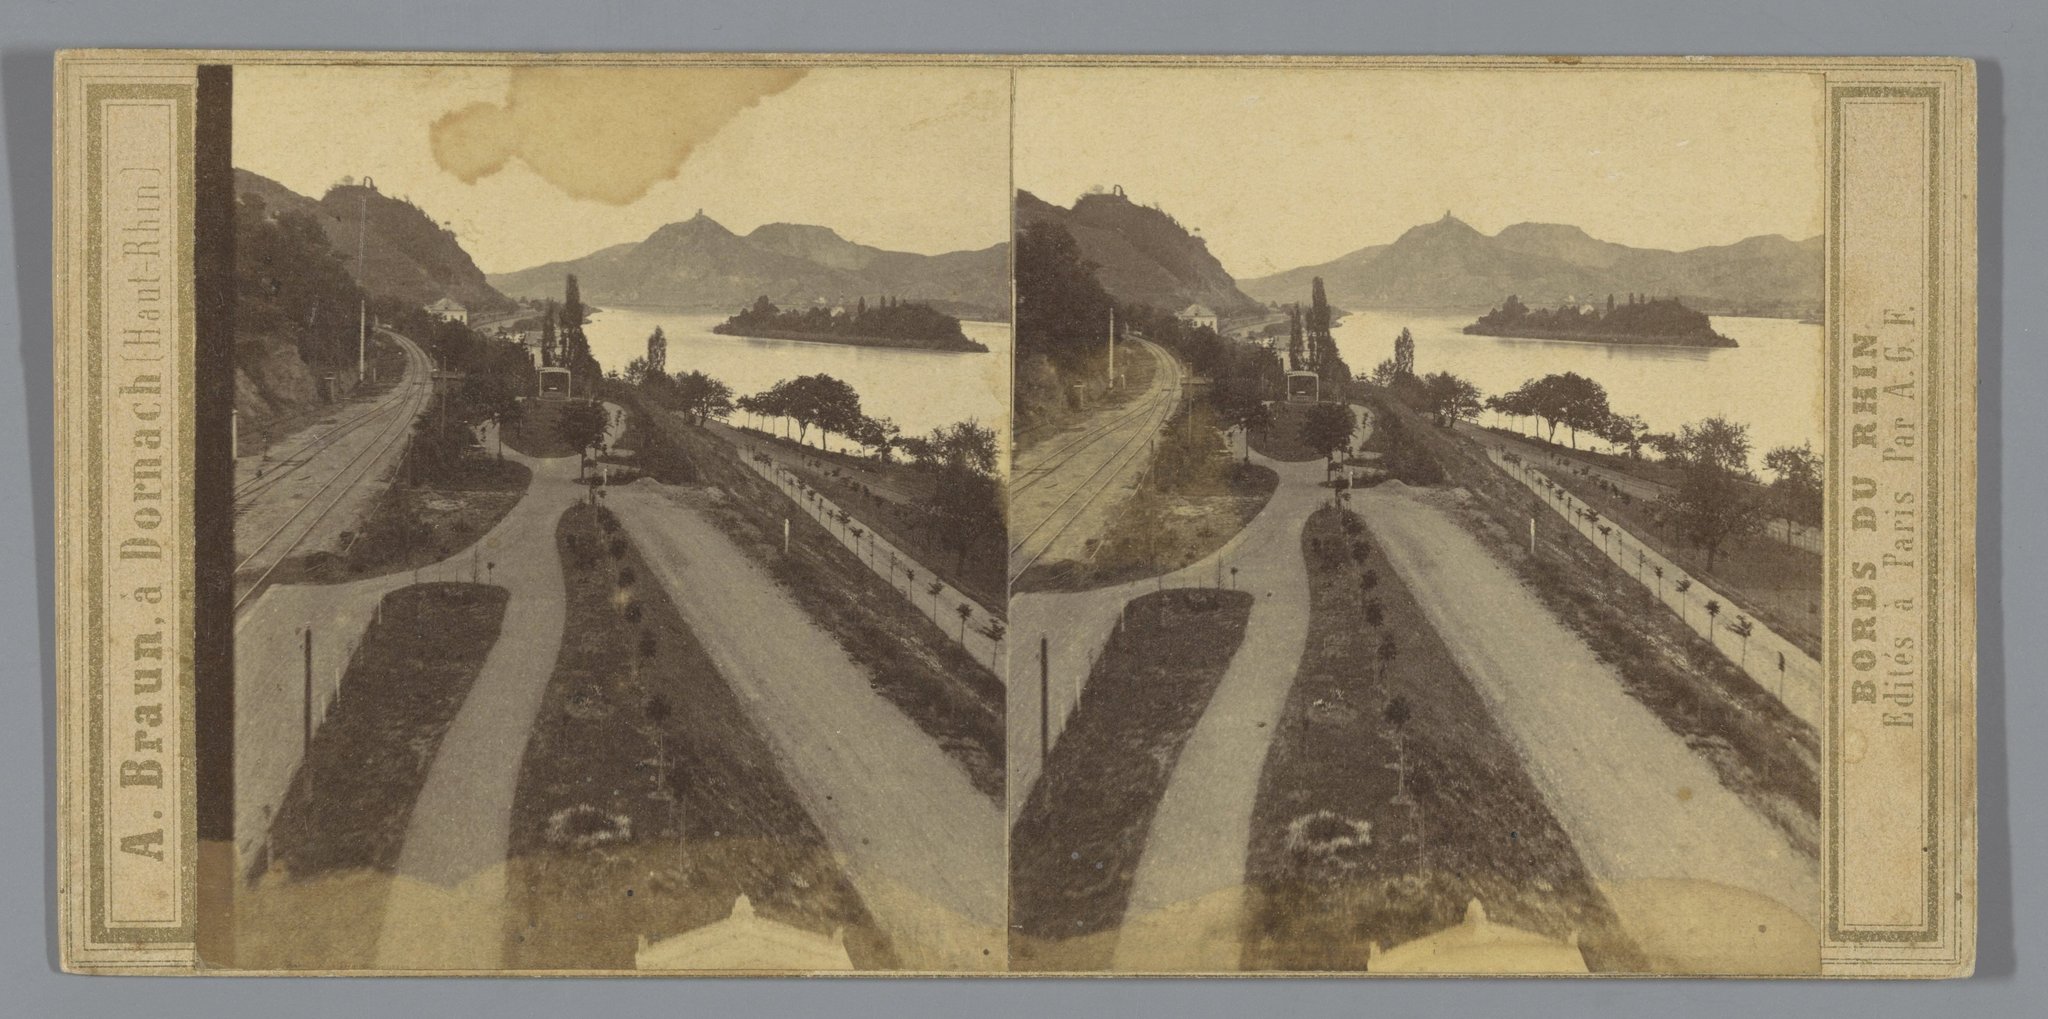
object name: stereograph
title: Bords du Rhin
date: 1860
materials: cardboard, paper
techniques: albumen print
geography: dornach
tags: island, city-view in general; 'veduta', river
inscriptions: number: ‘802.’, number: ‘14.’